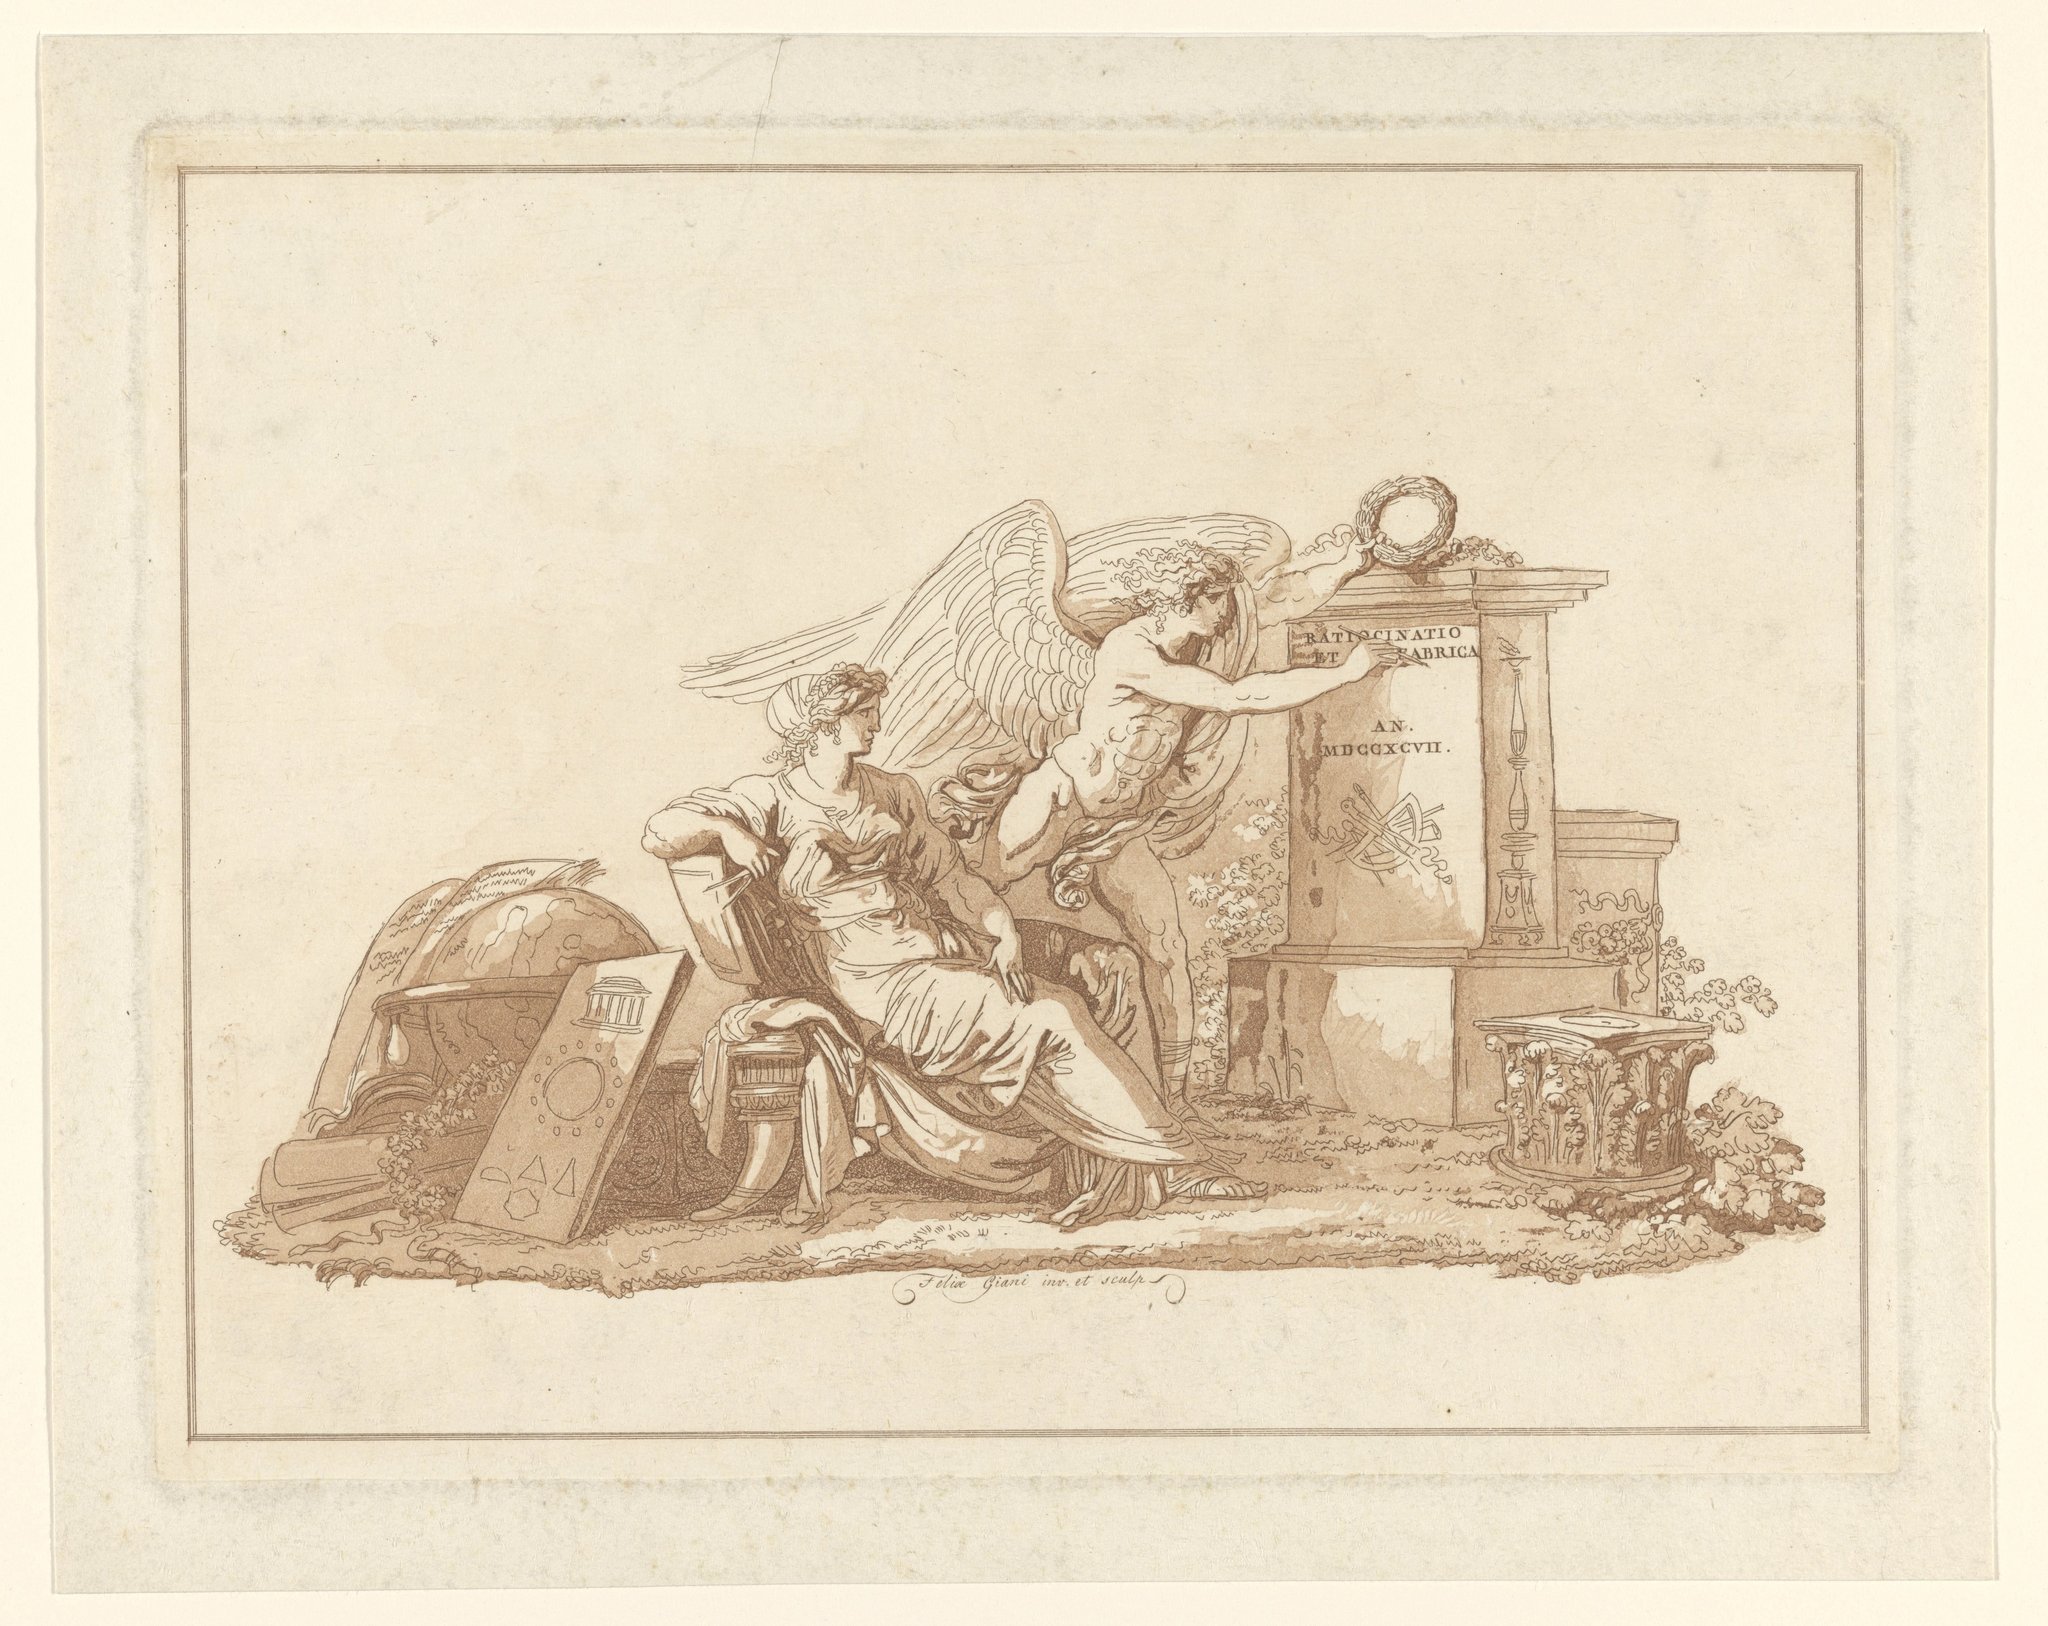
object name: print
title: Allegorie op de architectuur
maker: felice giani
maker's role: draughtsman, painter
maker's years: 1758-1823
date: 1797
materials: paper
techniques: aquatint, etching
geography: italy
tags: 'architectura', symbolic representations, allegories and emblems ~ architecture; 'architettura' (ripa)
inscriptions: collector's mark: Lugt 2228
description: Titelblad voor: Raccolta di XI progetti achetettonici indentation e designate. Allegorie op de architectuur met een zittende vrouwelijke personificatie en de schrijvende genius van de Schone Kunsten.